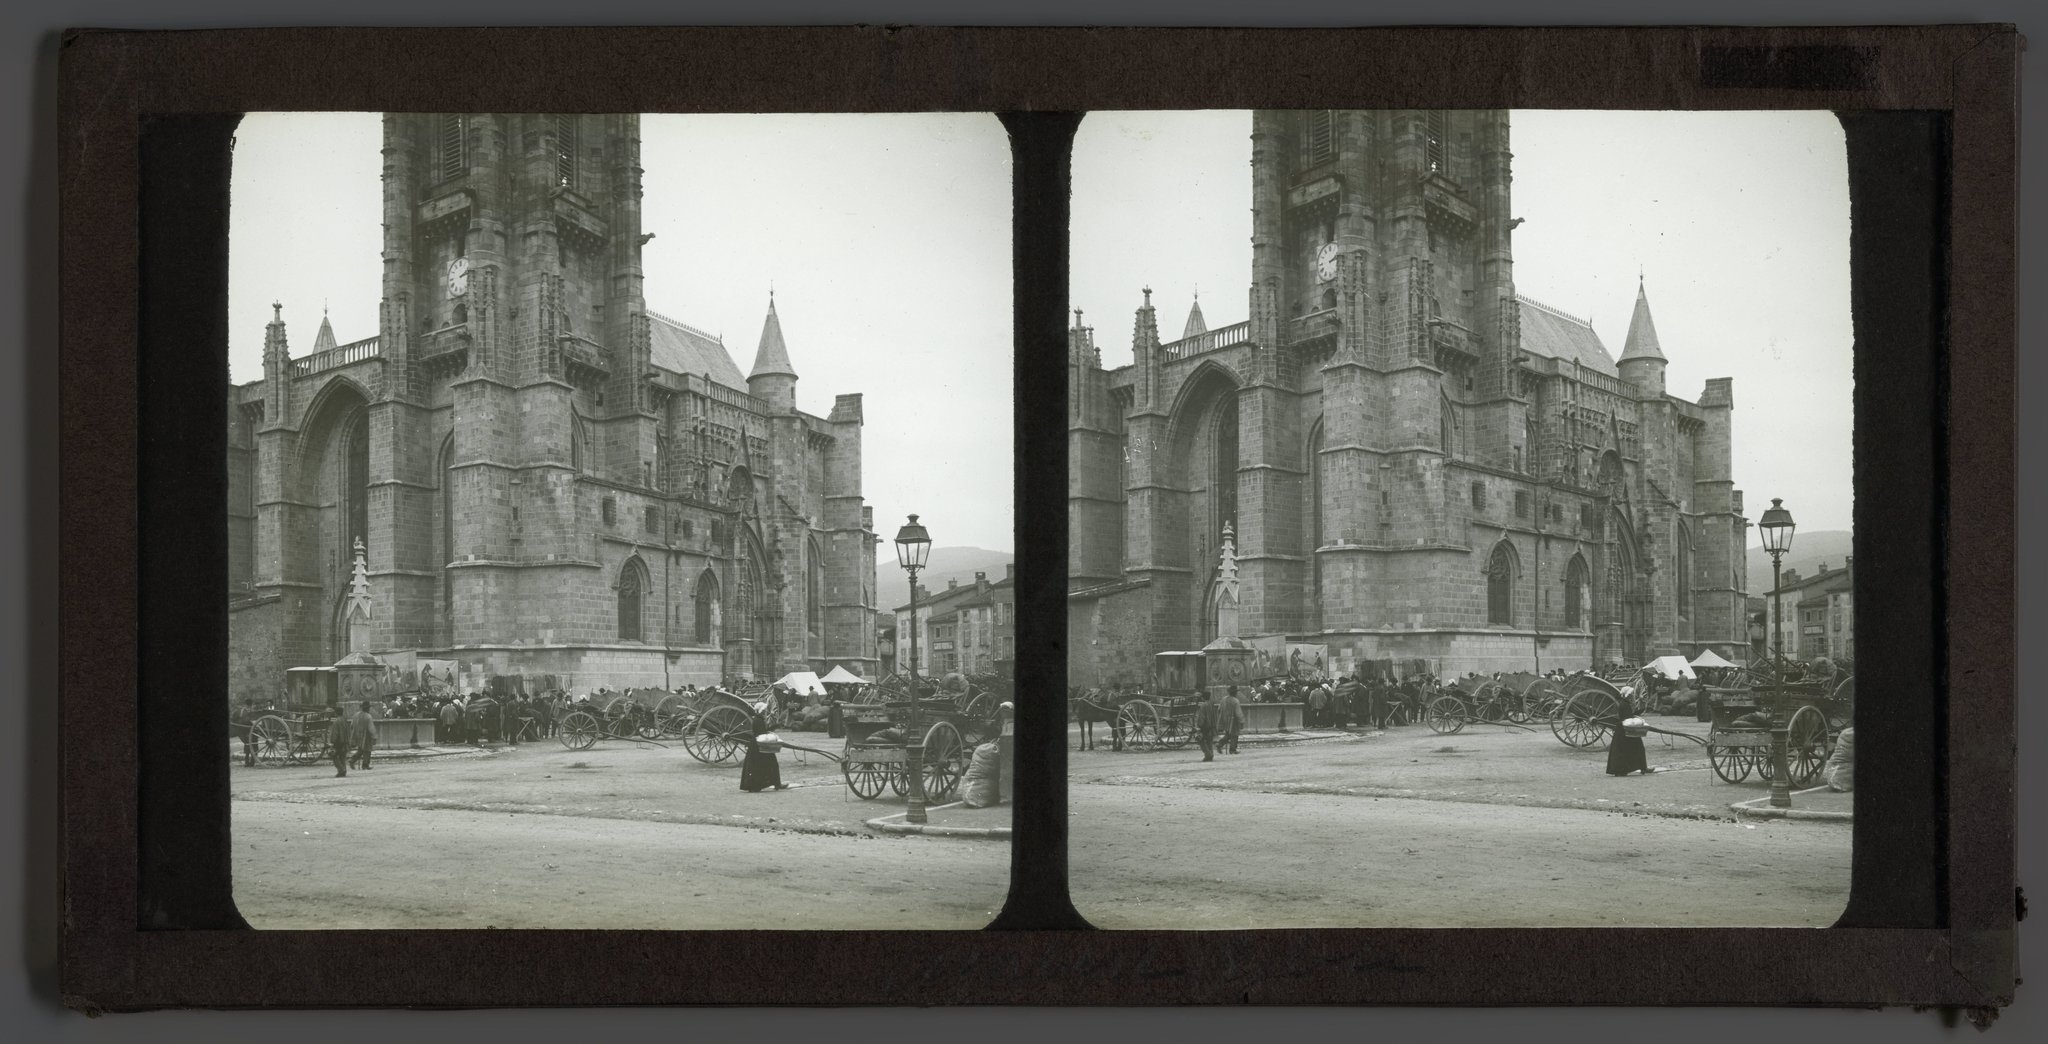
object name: stereoscopic photograph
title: Exterieur van de Église de Saint-Jean te Ambert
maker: Anonymous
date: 1860-1890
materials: glass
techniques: slide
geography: ambert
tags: church (exterior)